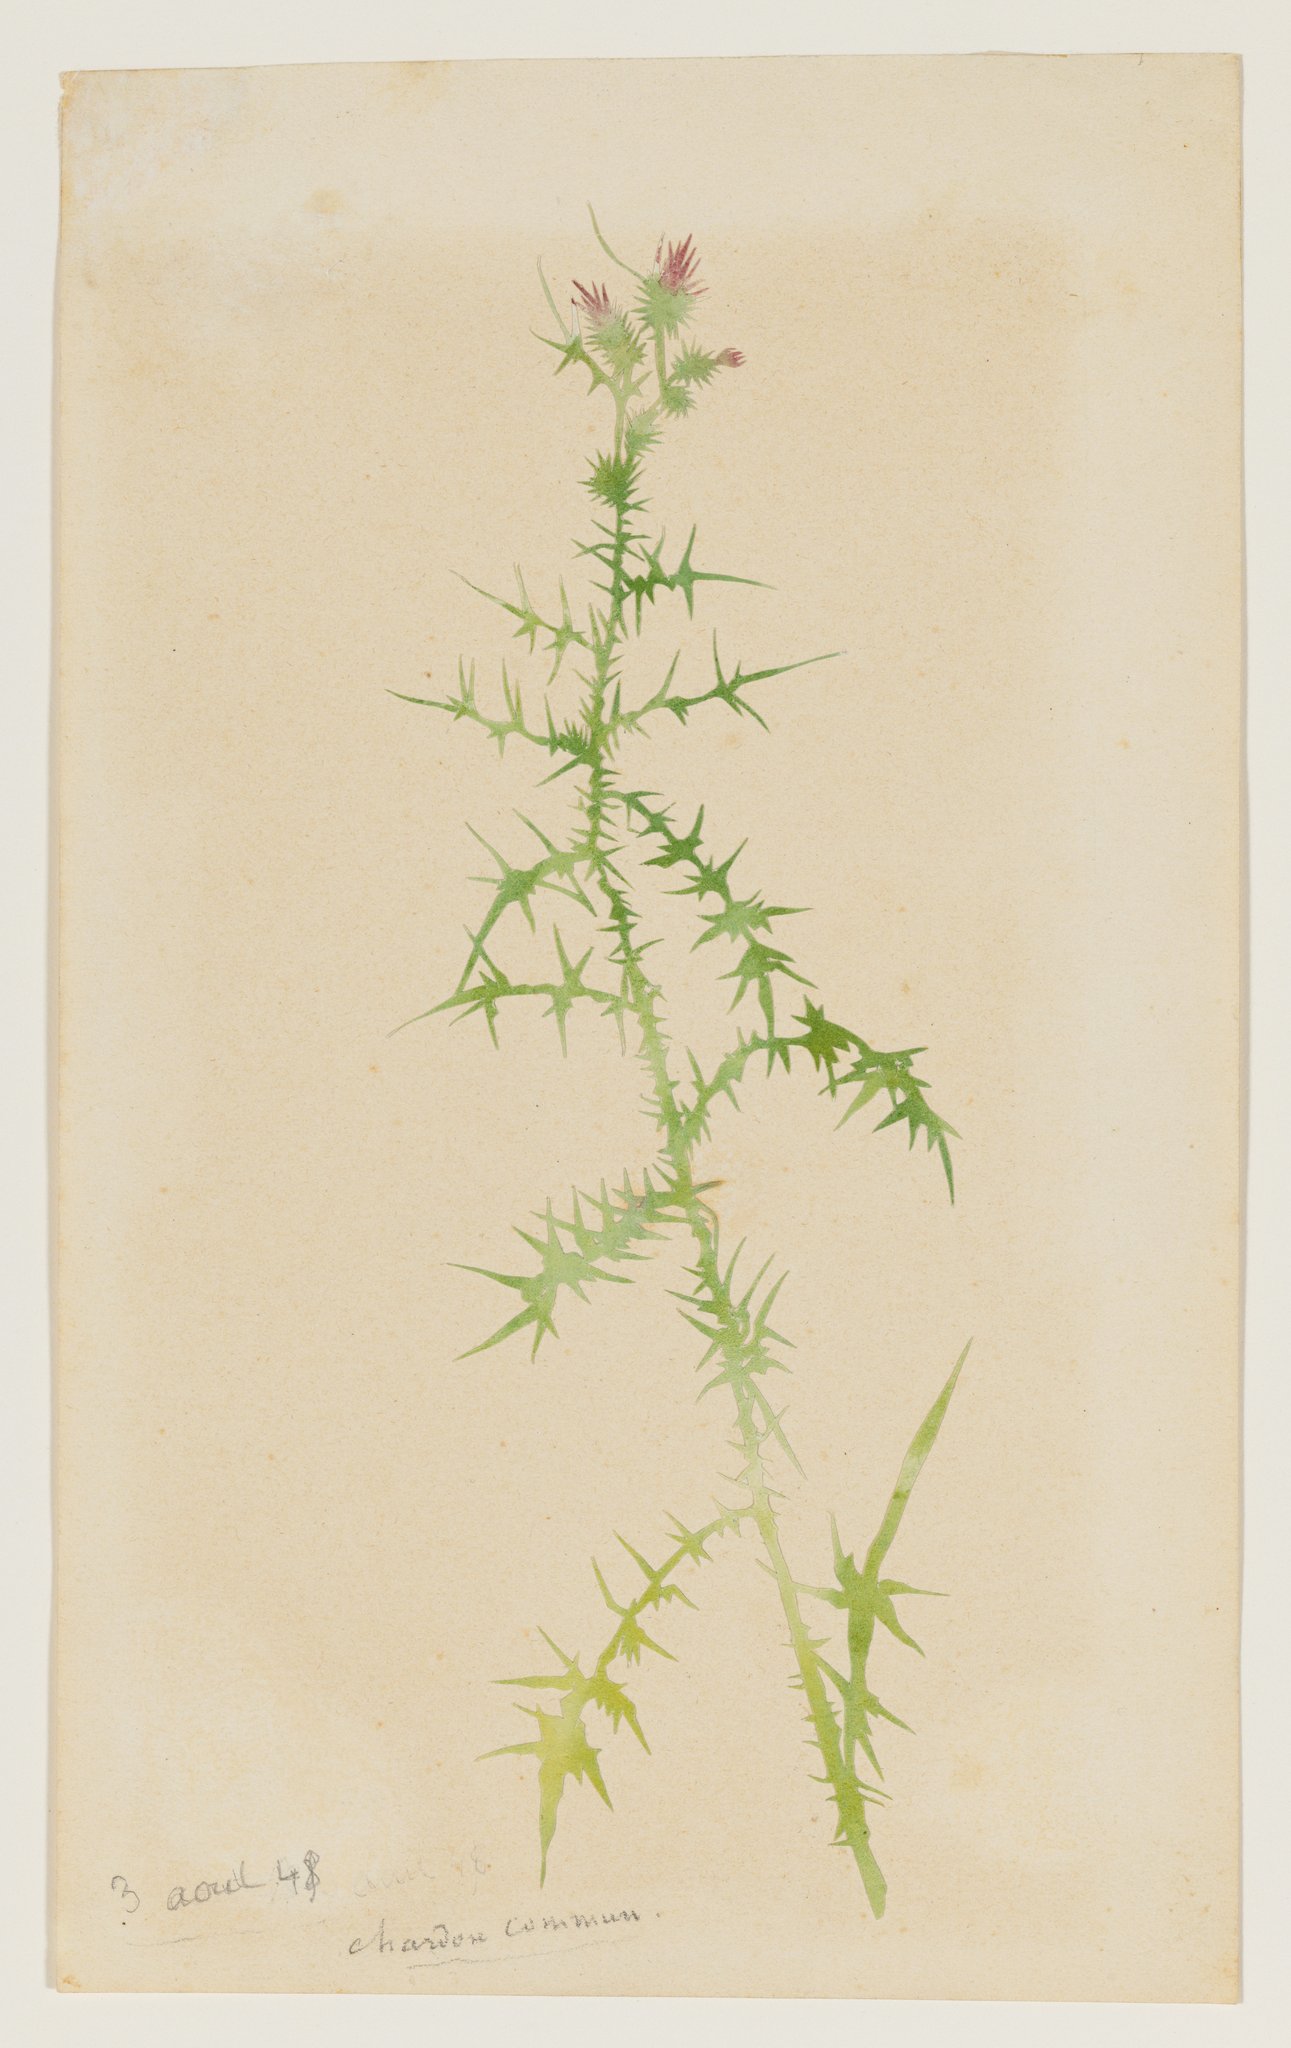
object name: drawing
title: Common Thistle (Chardon Commun)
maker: george sand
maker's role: artist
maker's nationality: french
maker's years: 1804-1876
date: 1848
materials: watercolor